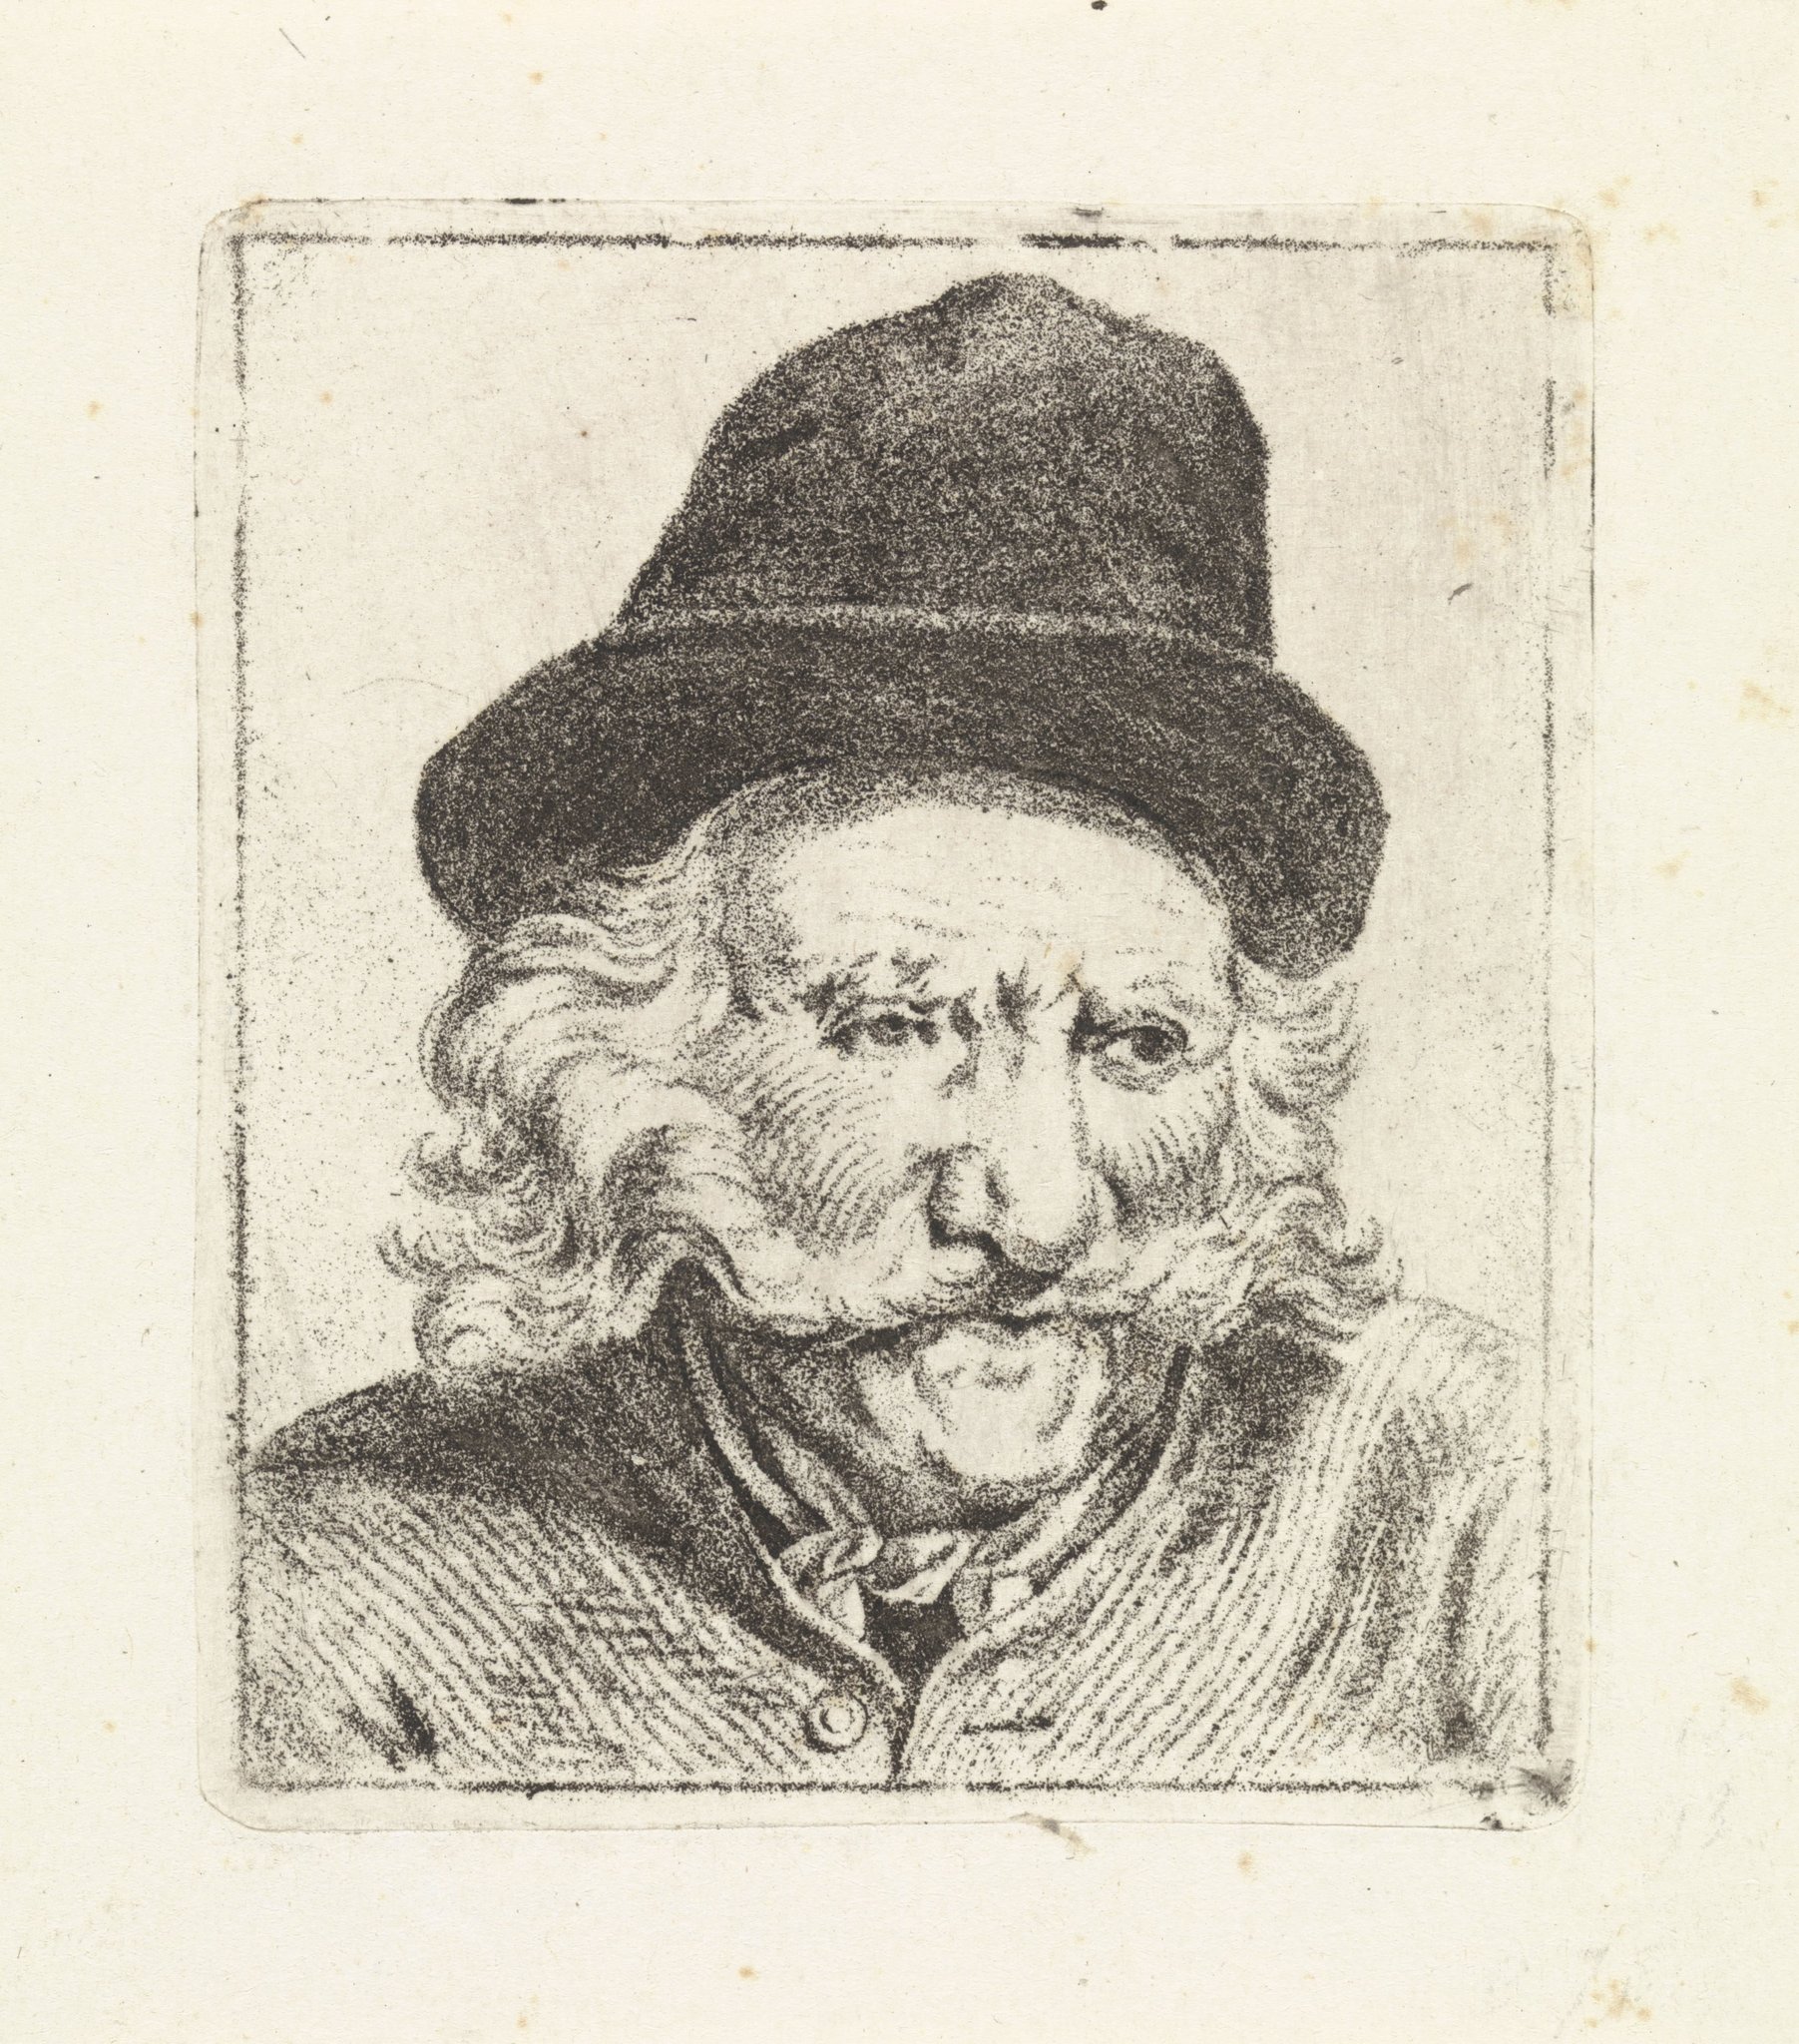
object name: print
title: Portret van Jan Kuiper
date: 1739-1851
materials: paper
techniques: soft ground etching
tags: jan kuiper (jan practiseer)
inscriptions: collector's mark: Lugt 2228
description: Portret van Jan Kuiper, bijgenaamd Jan Practiseer. Hij draagt een hoed en een sjaal.